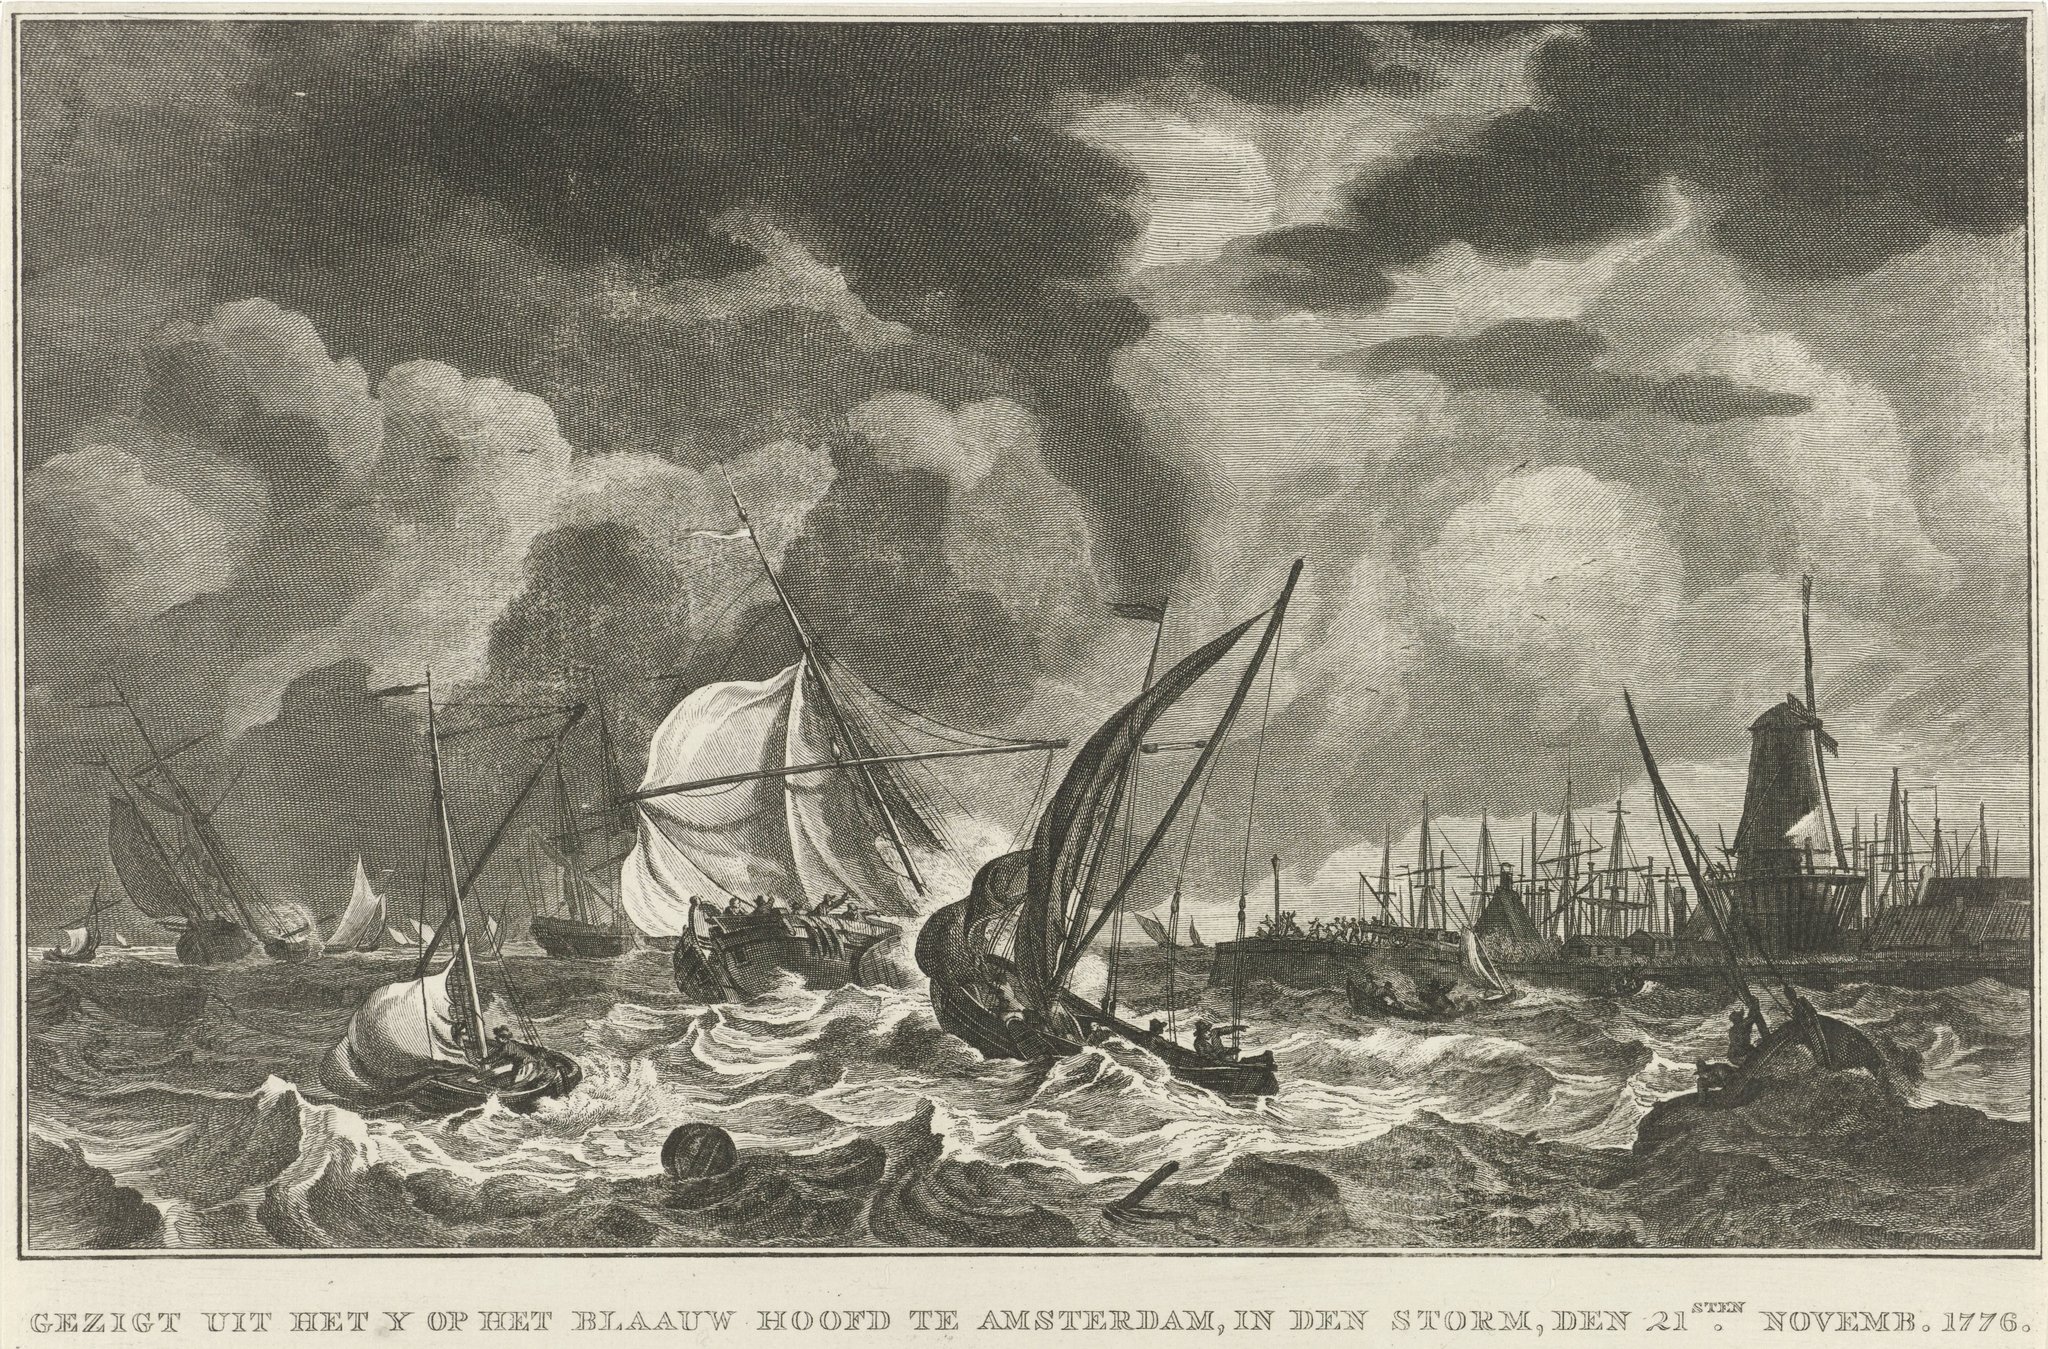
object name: print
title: Gezicht uit het Y op het Blaauw Hoofd te Amsterdam, in den storm, den 21.sten novemb. 1776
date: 1778-1787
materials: paper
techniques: engraving, etching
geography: amsterdam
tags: sailing-ship, sailing-boat, storm at sea, amsterdam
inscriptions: collector's mark: Lugt 2228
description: Zeilschepen in de problemen op het IJ ter hoogte van het Blauwhoofd te Amsterdam op 21 november 1776.